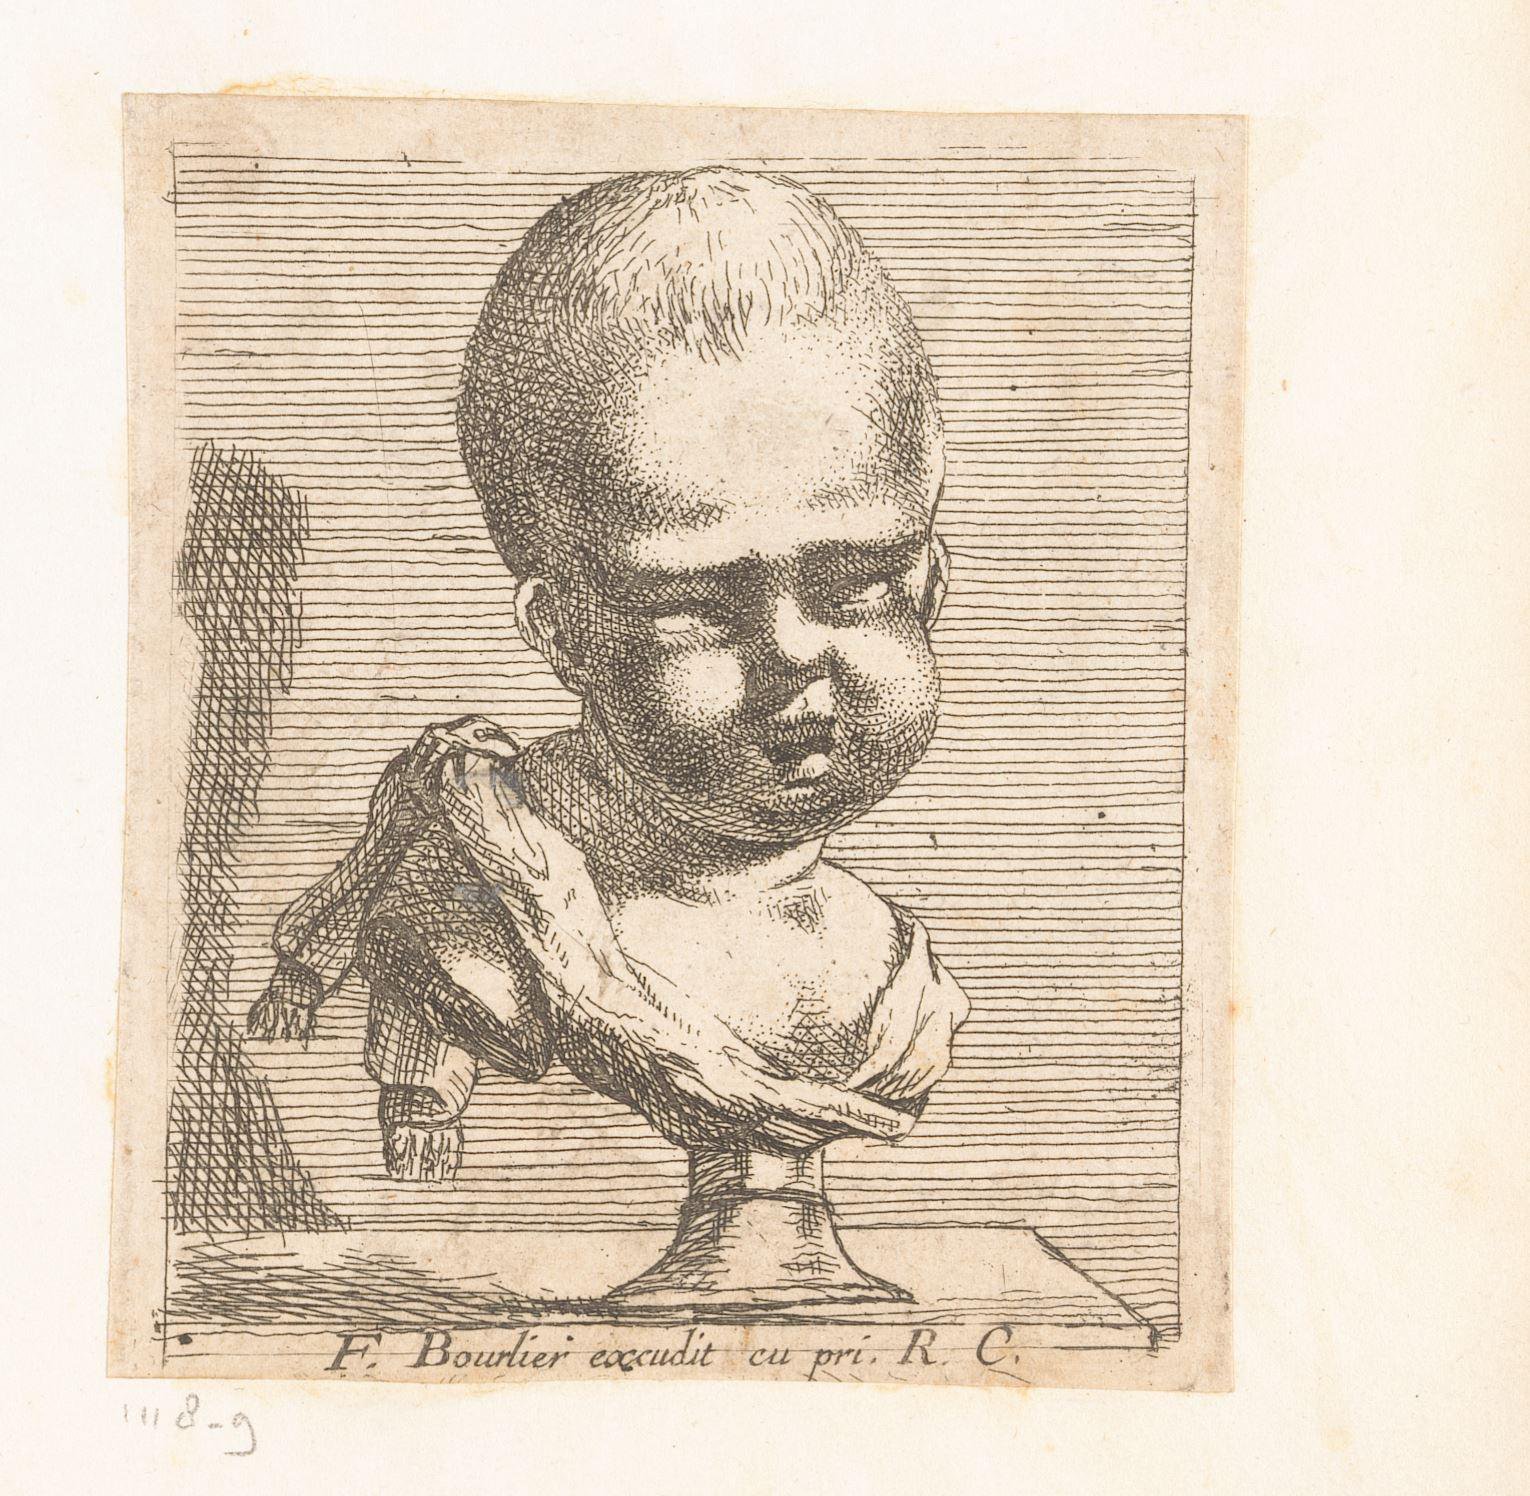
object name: print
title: Herm met kindergezicht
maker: françois bourlier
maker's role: draughtsman, painter, print maker, publisher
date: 1660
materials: paper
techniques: etching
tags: herms (garden ornaments), ornament ~ human parts, child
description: Herm met het hoofd van een kind. Onderdeel van een groep van negen bladen van zes verschillende kopjes.